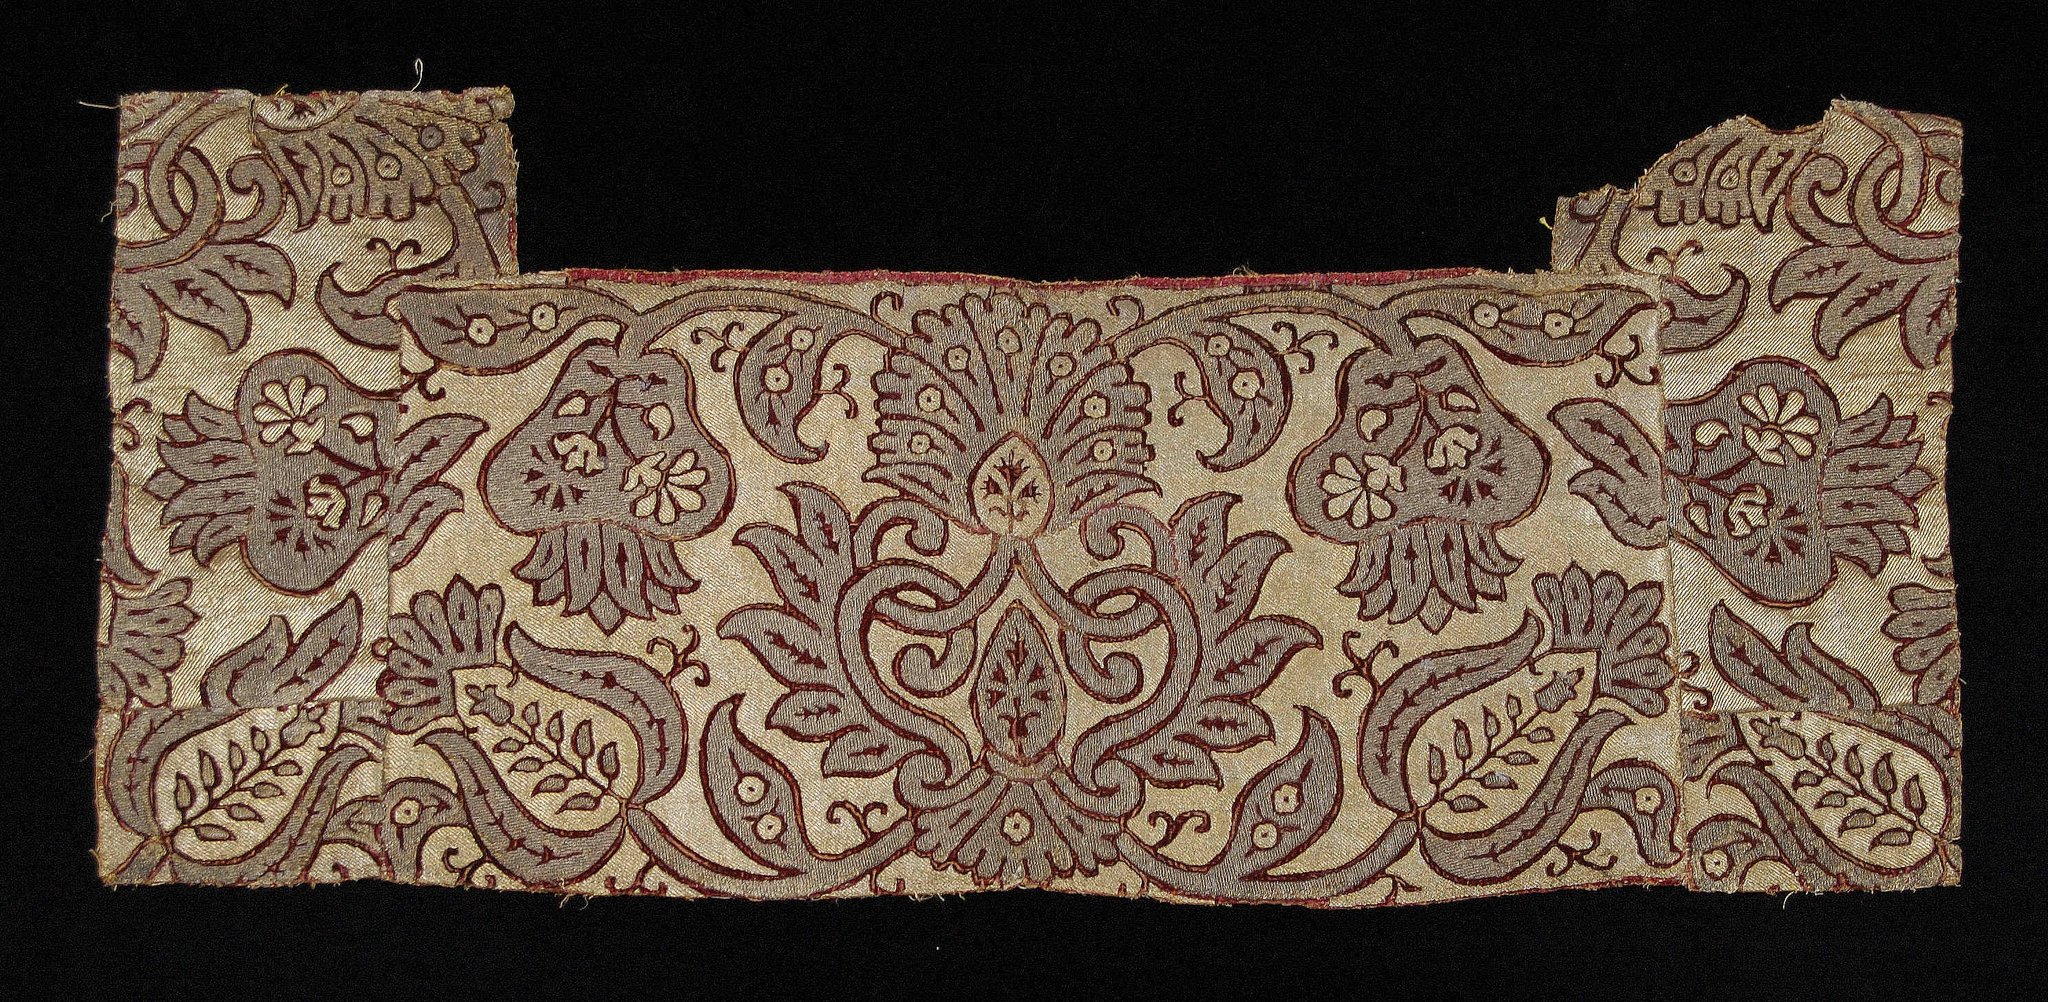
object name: textile panel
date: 1650-1699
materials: linen, silk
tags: flowers,leaves